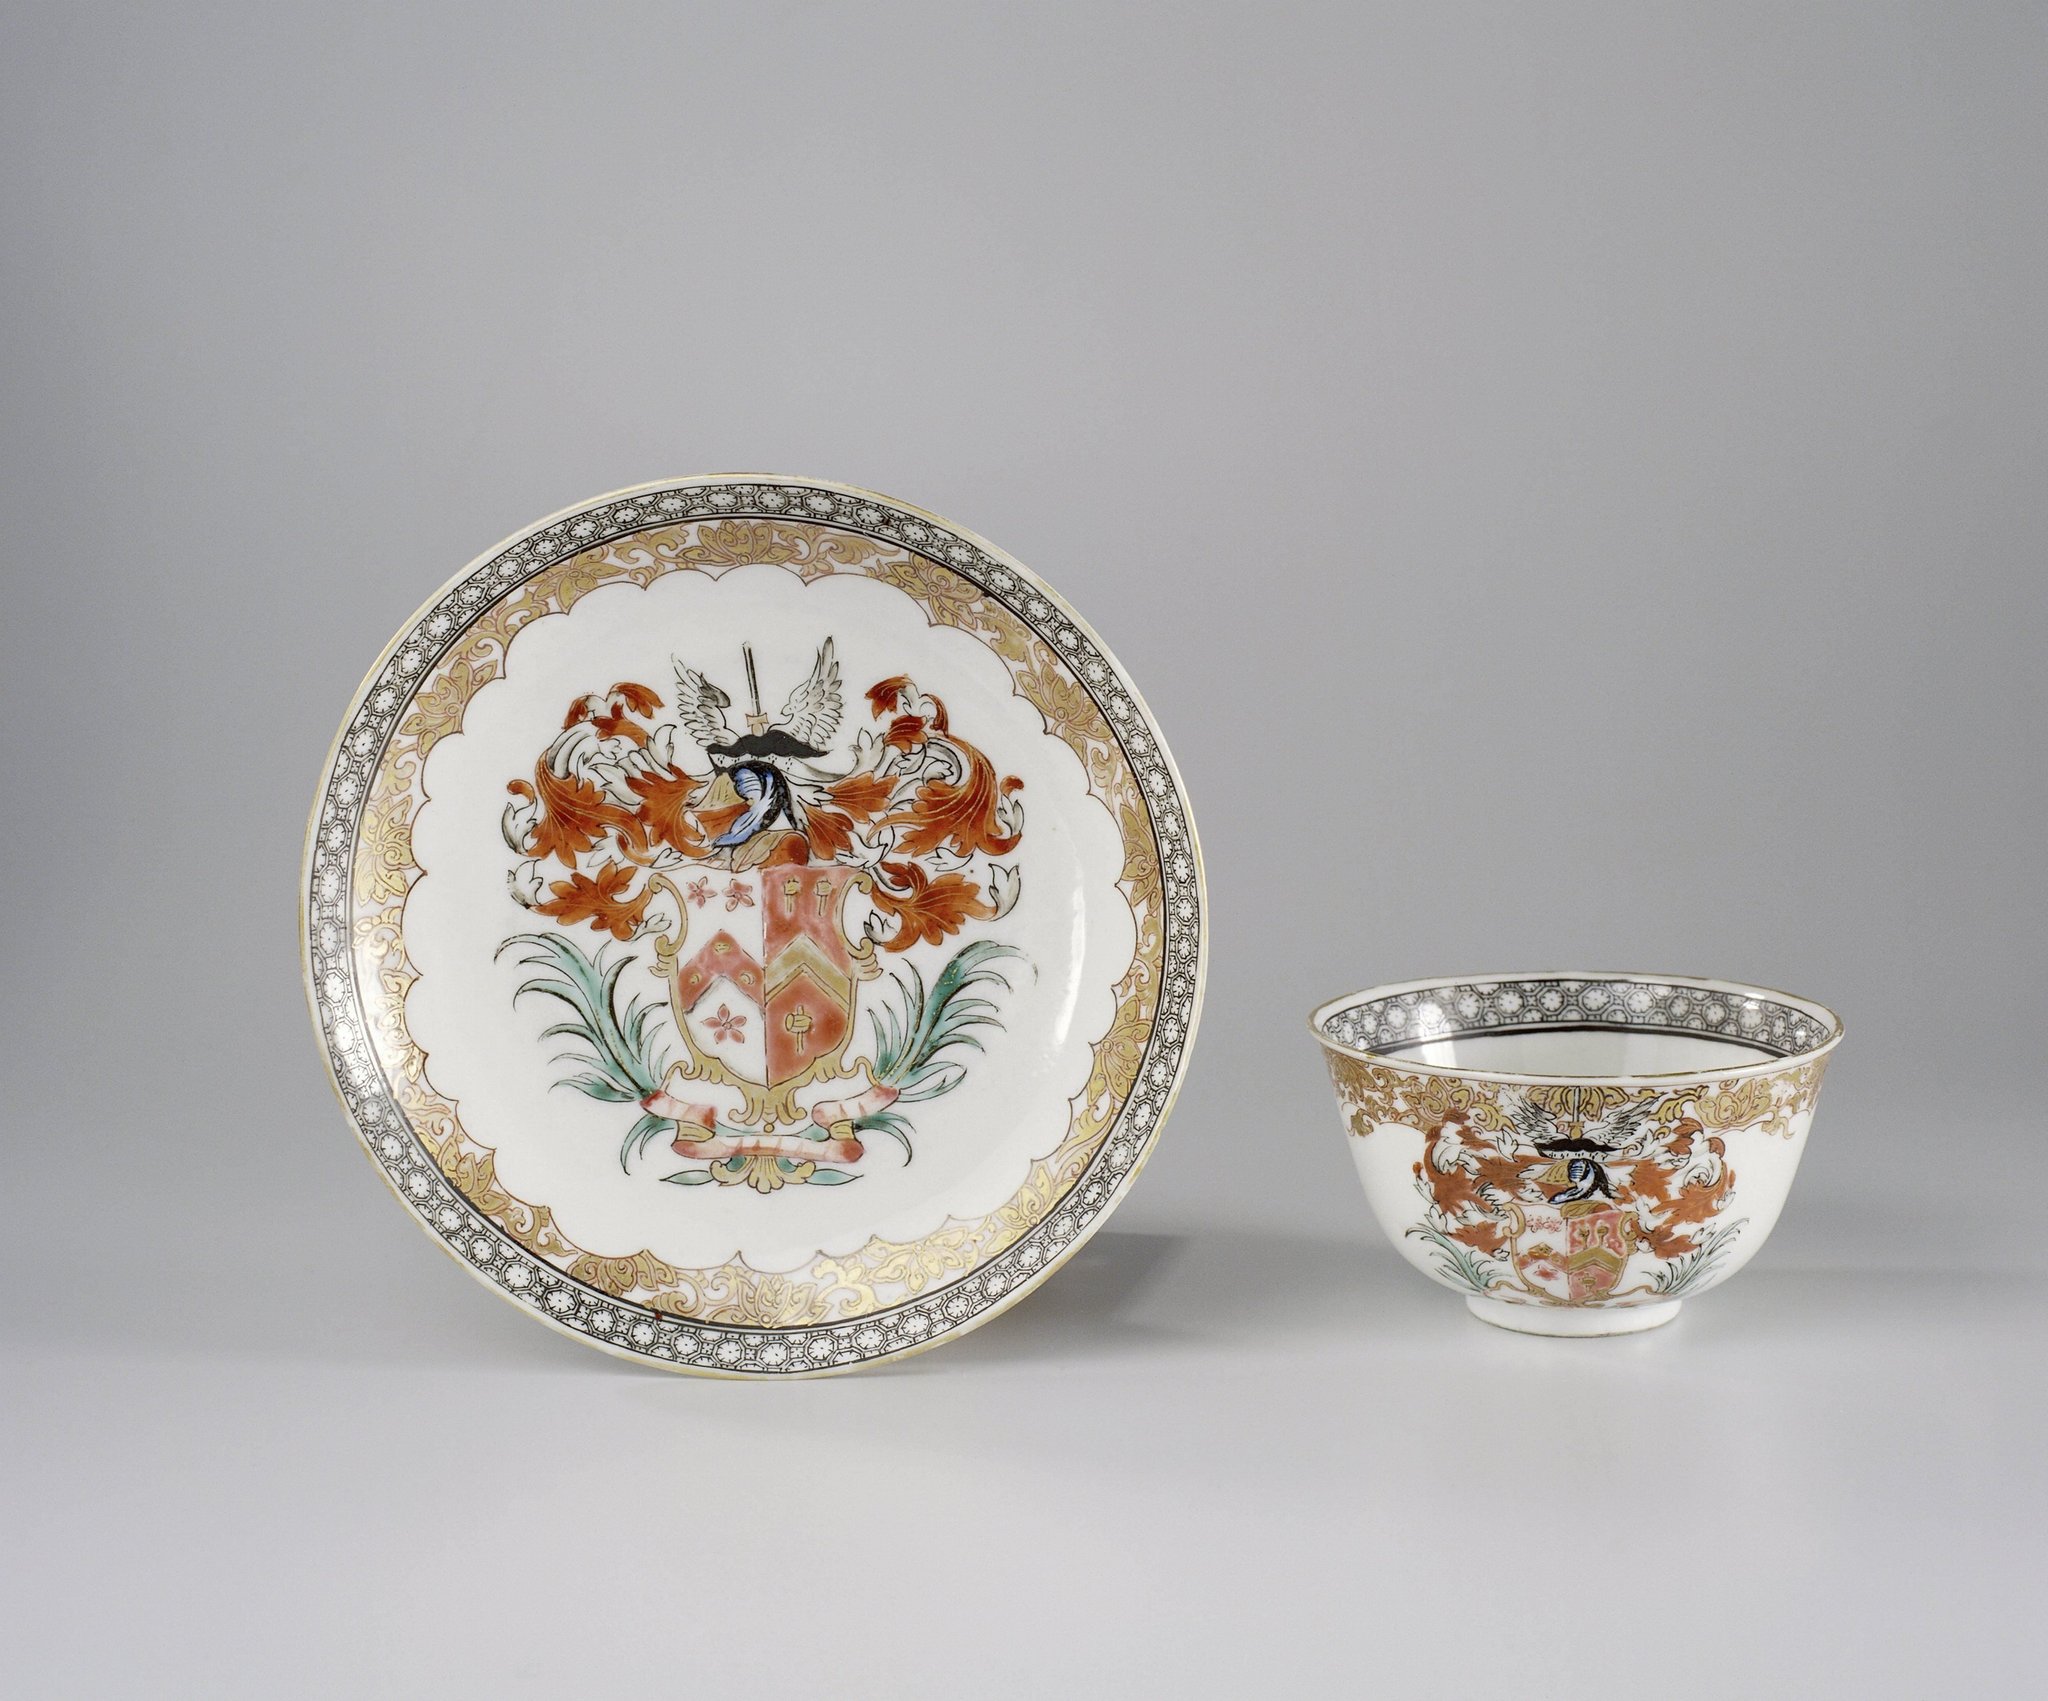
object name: kop en schotel, kop en schotel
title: Bell-shaped cup and saucer with the arms of the Yaldwin and Soame family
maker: Anonymous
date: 1740-1760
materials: glaze, gold, paint, porcelain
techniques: firing, gilding, turning, vitrification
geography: china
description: Klokvormige kop en schotel van porselein, beschilderd op het glazuur in blauw, rood, roze, groen, zwart en goud. Op het plat het wapen van de families Yaldwin en Soame. Links Yaldwin met drie bloemen tegen een witte achtergrond en in het midden een rode keper met twee gele bollen en een leeuwenkop; rechts Soame met drie hamers op een rode achtergrond en een gouden keper in het midden. Het helmteken is een gevleugeld zwaard omgeven door acanthusbladeren. Aan weerszijden van het wapen een palmtak. Op de wand een band met lotusranken en één met servetwerk. De kop met dezelfde decoratie. Een barst in de rand van de kop. Wapenporselein met emailkleuren.